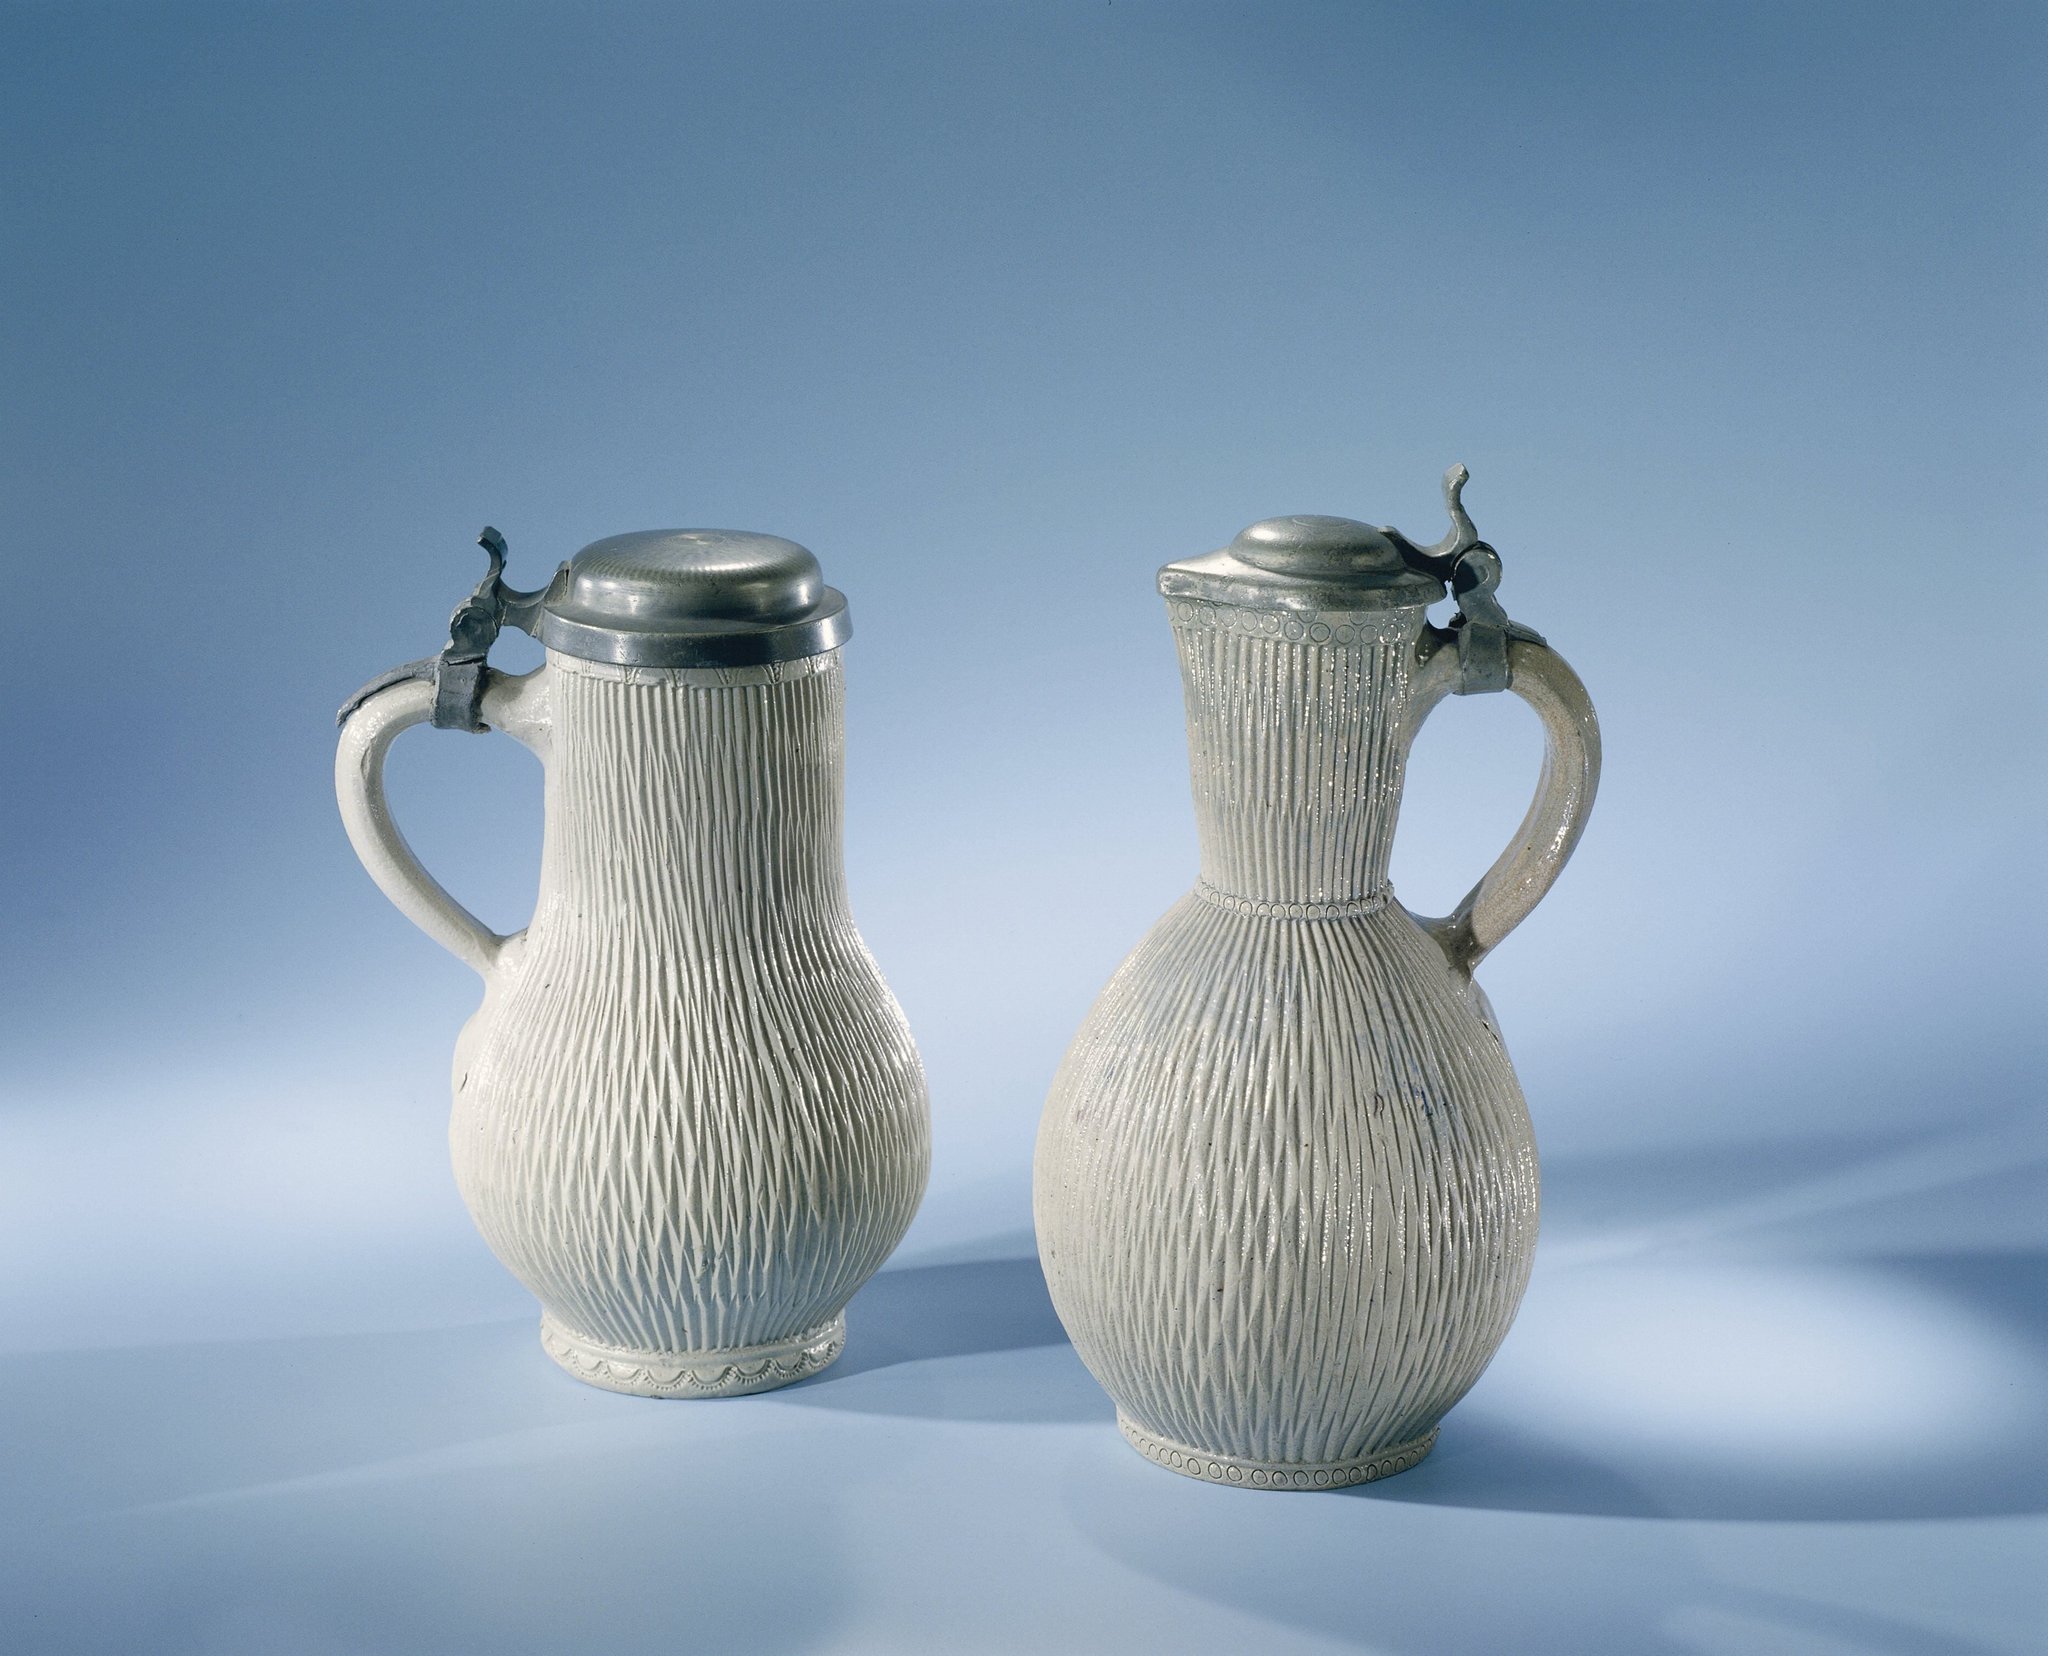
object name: ewer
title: Chip-carved jug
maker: Anonymous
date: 1750-1780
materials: glaze, stoneware, tin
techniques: firing, turning, vitrification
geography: westerwald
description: Kan van steengoed op standring met een eivormig lichaam en smalle nek met geknepen tuit. Het C-vormige oor is bevestigd aan de nek en de schouder. De kan is volledig bedekt met een kerfsnedeversiering. Op de voet, schouder en rand een smalle band met gestempelde cirkels. Aan het oor is een tinnen montuur met deksel bevestigd. Westerwald.